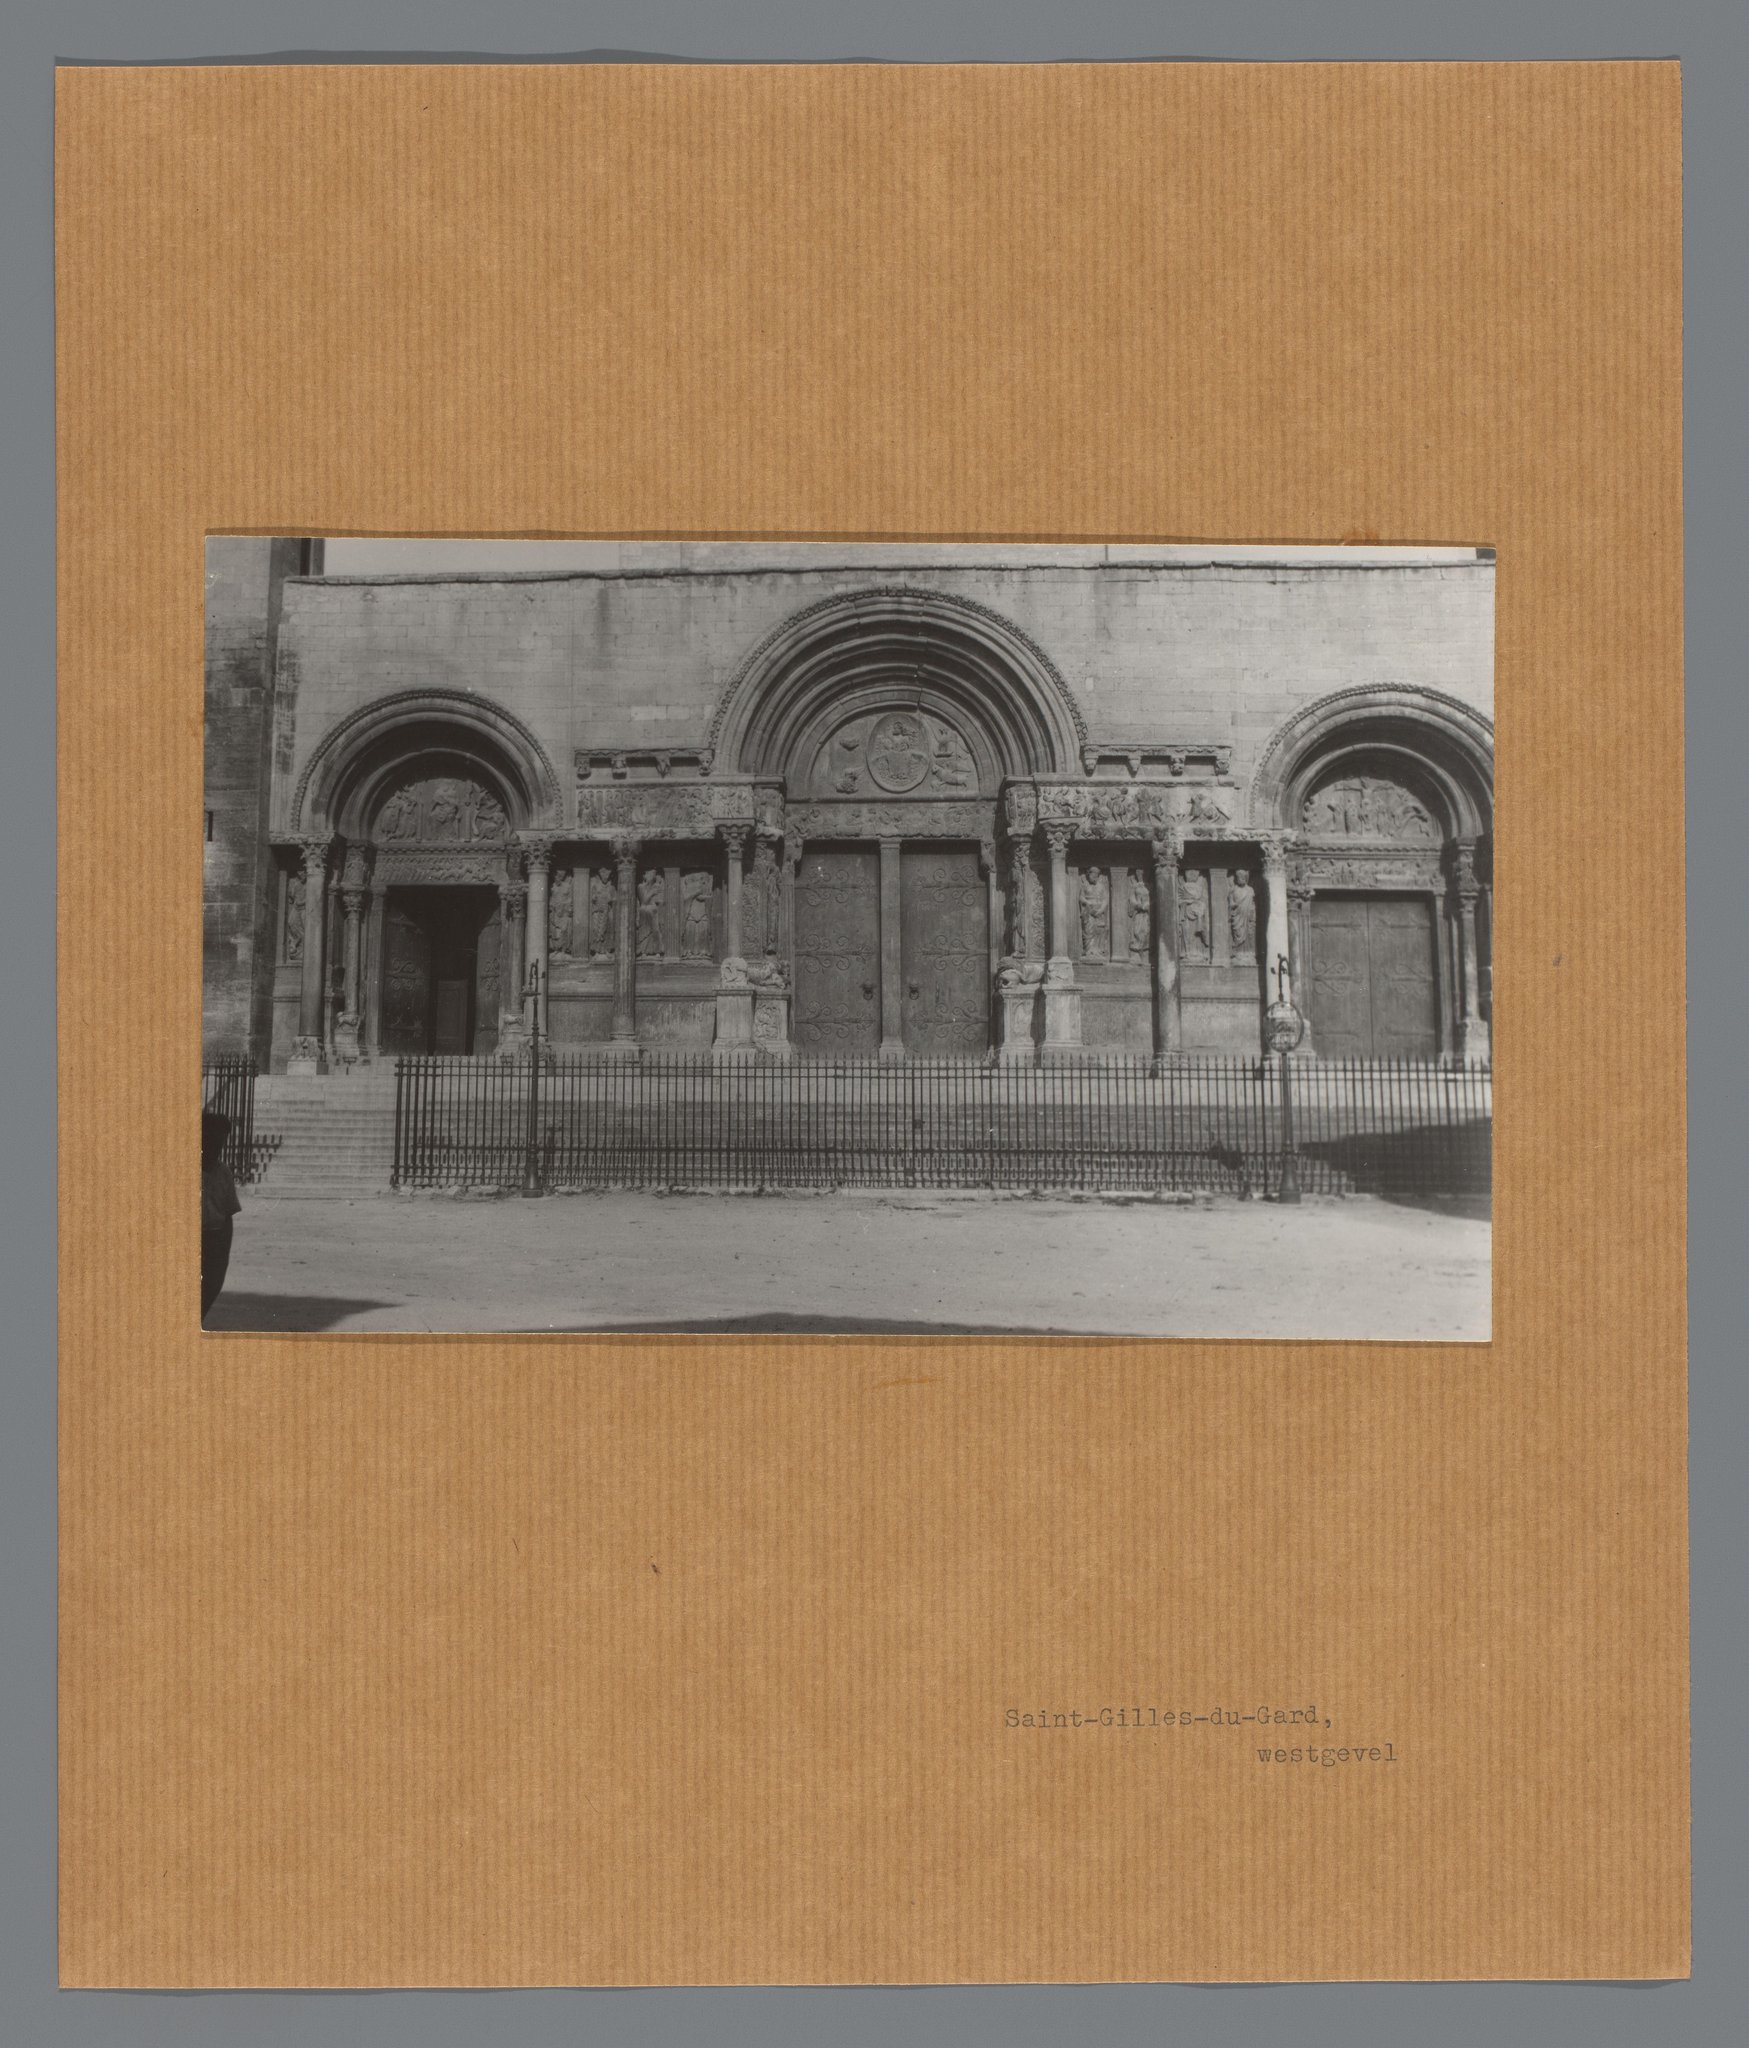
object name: photograph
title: Saint-Gilles, Kirche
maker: Anonymous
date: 1880-1930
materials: photographic support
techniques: gelatin silver print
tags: france